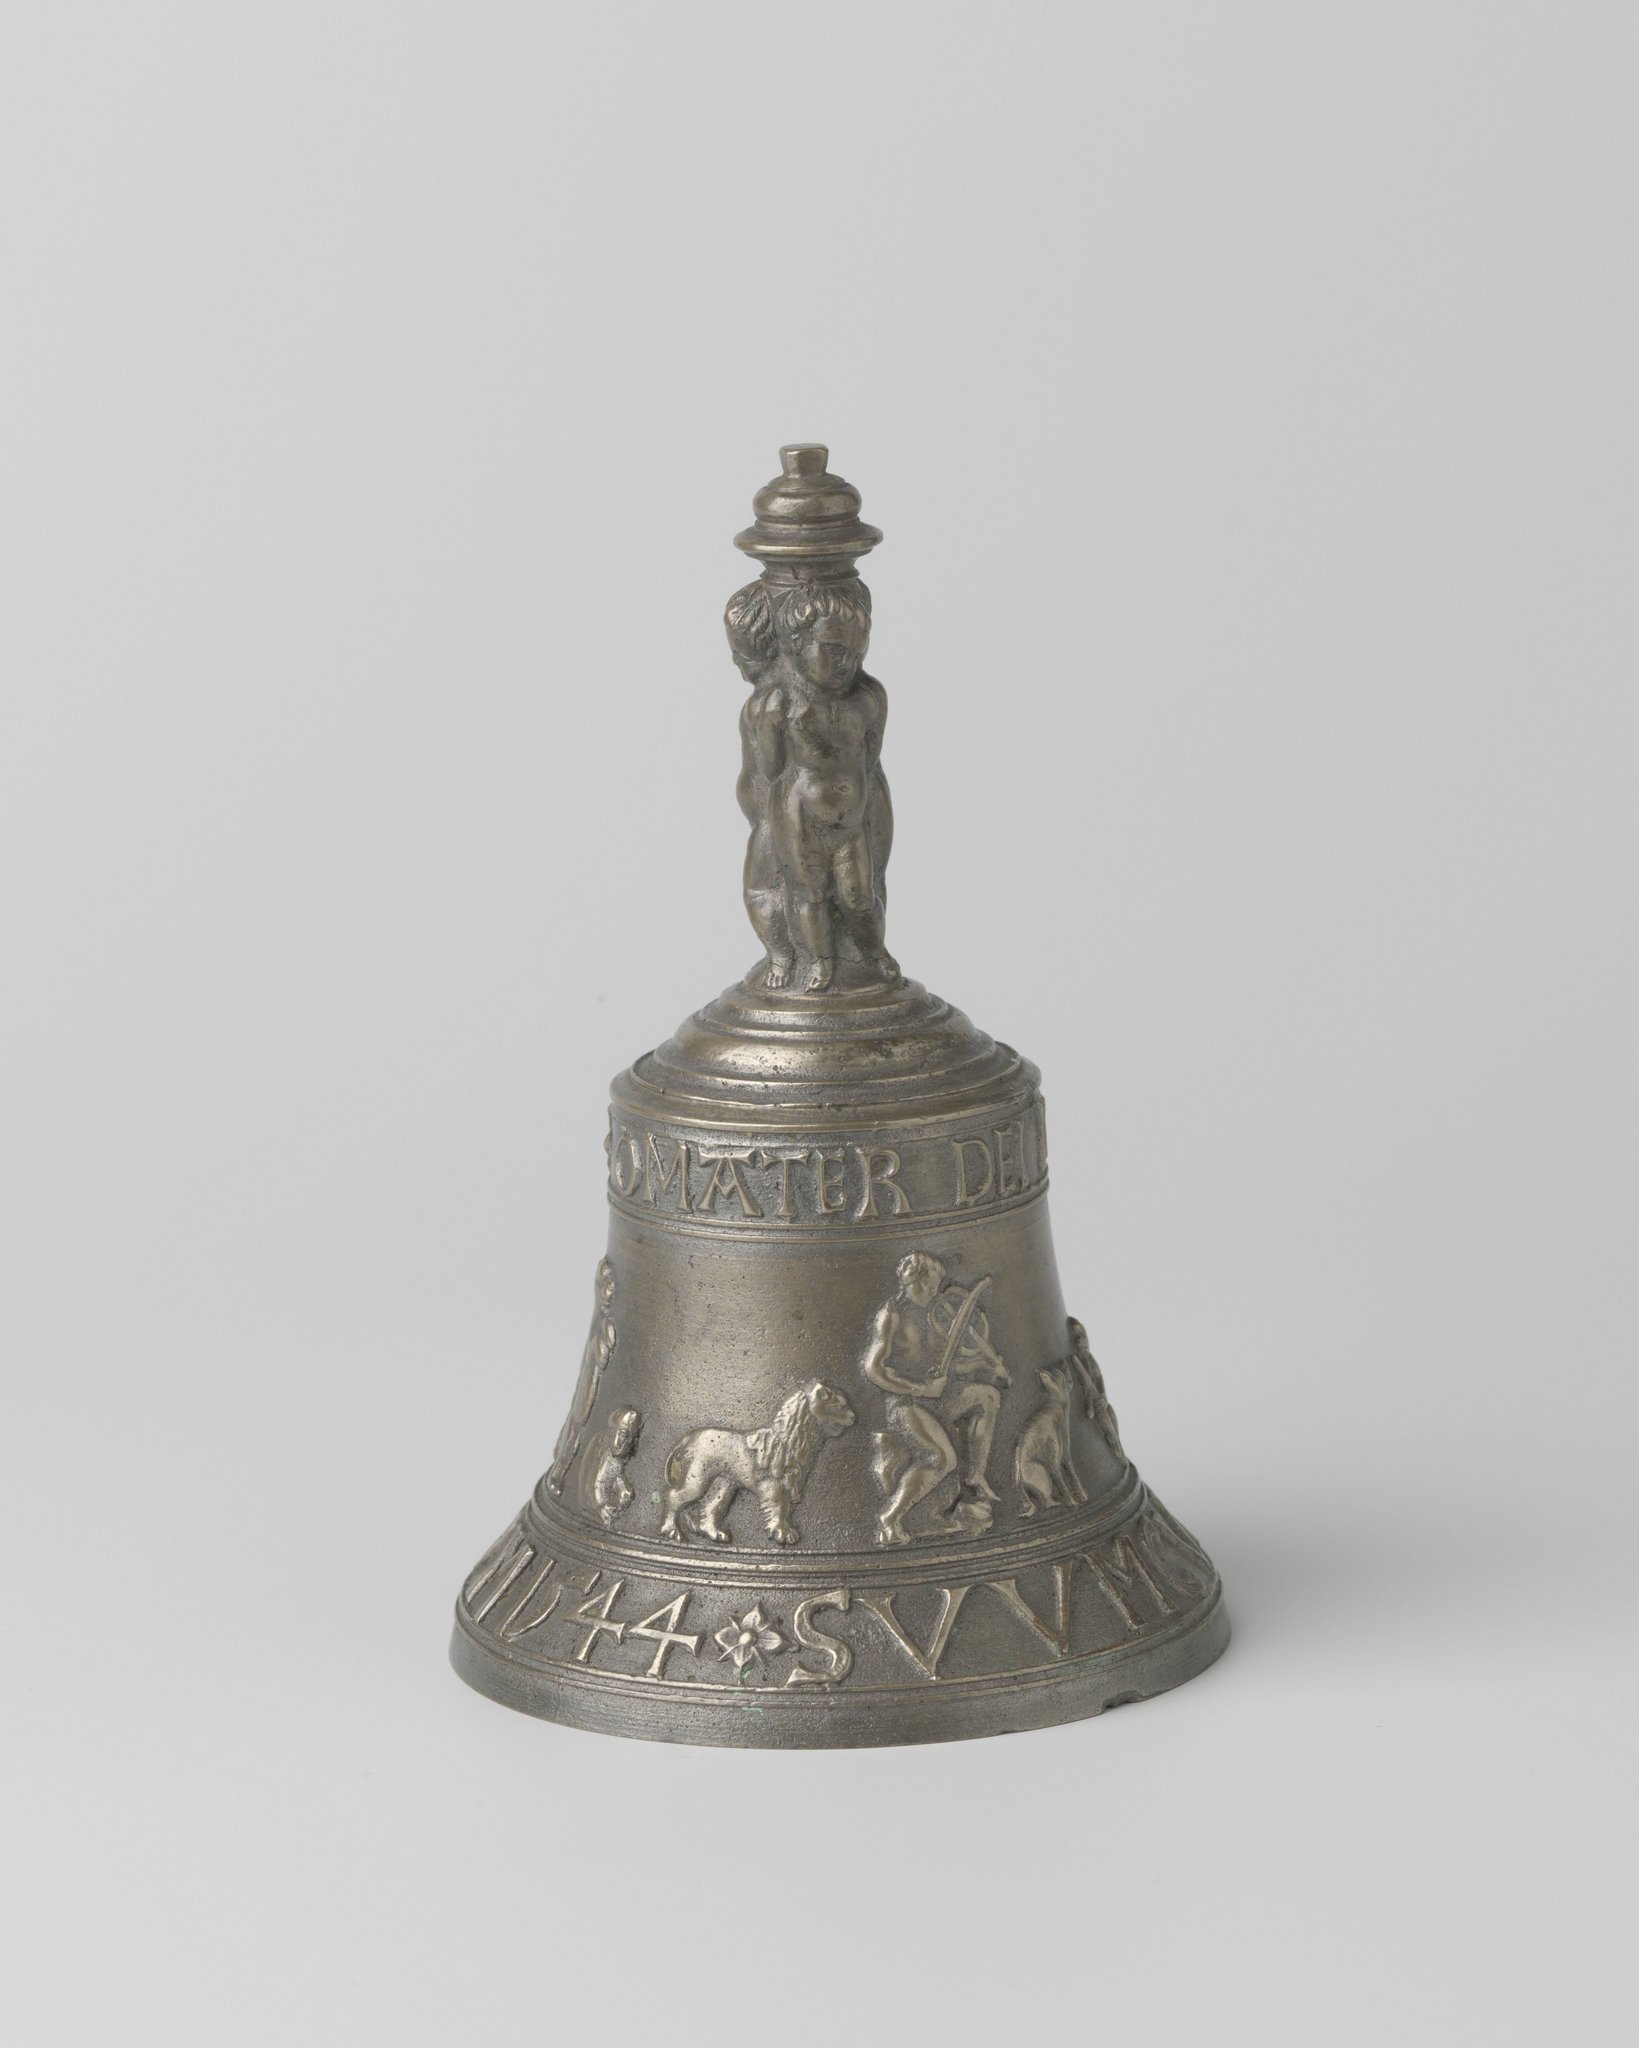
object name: musical instrument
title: Handbell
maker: johan van den eynde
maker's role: brazier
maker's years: 1515-1556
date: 1544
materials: bronze, iron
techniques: casting, granulation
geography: mechelen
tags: ram's head ~ ornament, ornament ~ festoon, garland, cupids: 'amores', 'amoretti', 'putti'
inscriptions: inscription: ‘ME FECIT PER IOHAN DE FINE Ao 1544*’, inscription: ‘LOFSI GODT VAN AL+’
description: Table bell with inscription: LOFSI GODT V AN AL(Praised be God above all). Bronze. Mechelen, 1544, Johan van den Eynde.